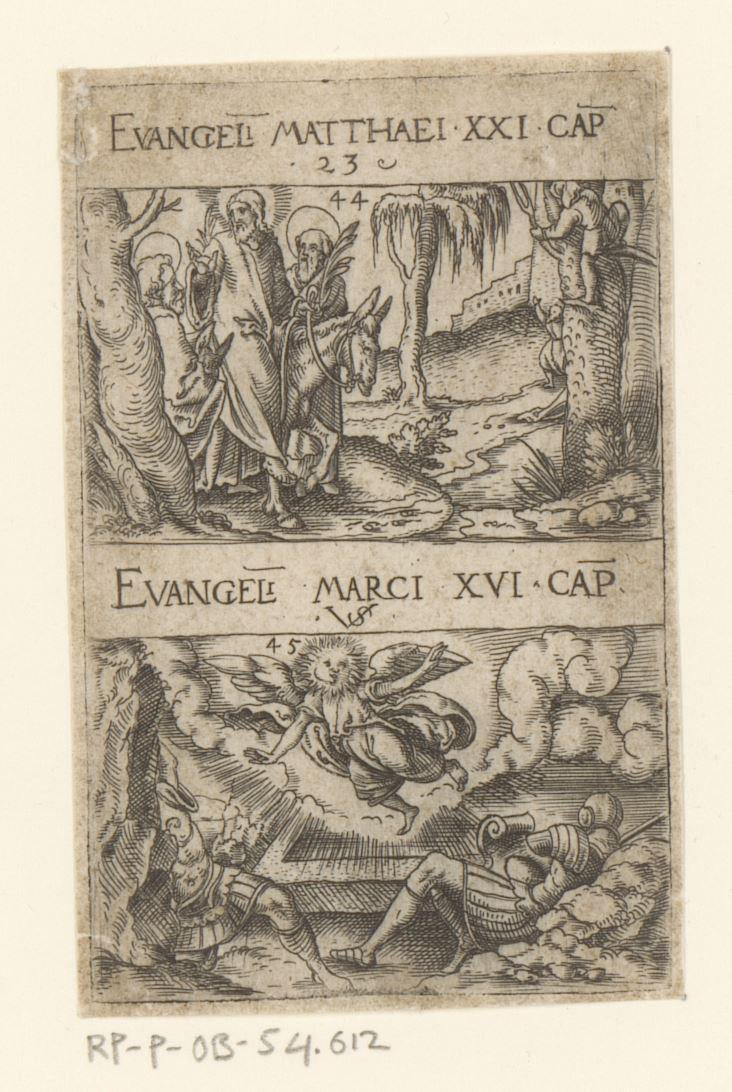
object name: print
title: Intocht in Jerusalem en de opstanding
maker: virgilius solis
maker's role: draughtsman, print maker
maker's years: 1514-1562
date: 1524-1562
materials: paper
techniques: engraving, etching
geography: nuremberg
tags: entry into jerusalem: people spreading their clothes before christ on the ass, and waving palm branches (matthew 21:1-11, 21:14-16; mark 11:1-11; luke 19:28-40; john 12:12-19), christ floating above or near the tomb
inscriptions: collector's mark: Lugt 2228, number: ‘88’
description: Deze prent maakt deel uit van een serie bestaande uit 27 genummerde prenten. De prenten tonen steeds twee evangelische scènes boven elkaar. Alle voorstellingen behalve de bovenste van de eerste prent zijn eveneens afzonderlijk genummerd.